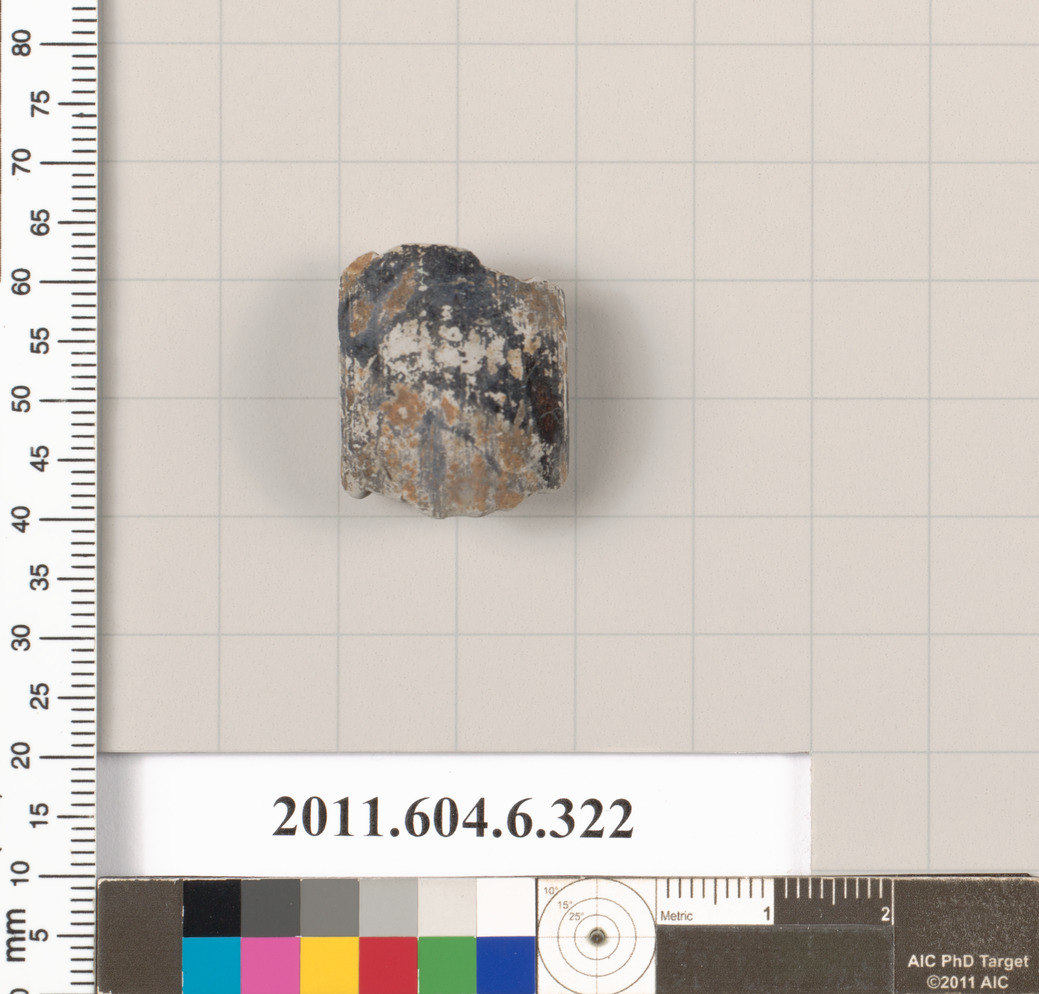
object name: undetermined shape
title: Terracotta fragment of an undetermined shape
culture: greek, attic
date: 600-401 BCE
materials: terracotta